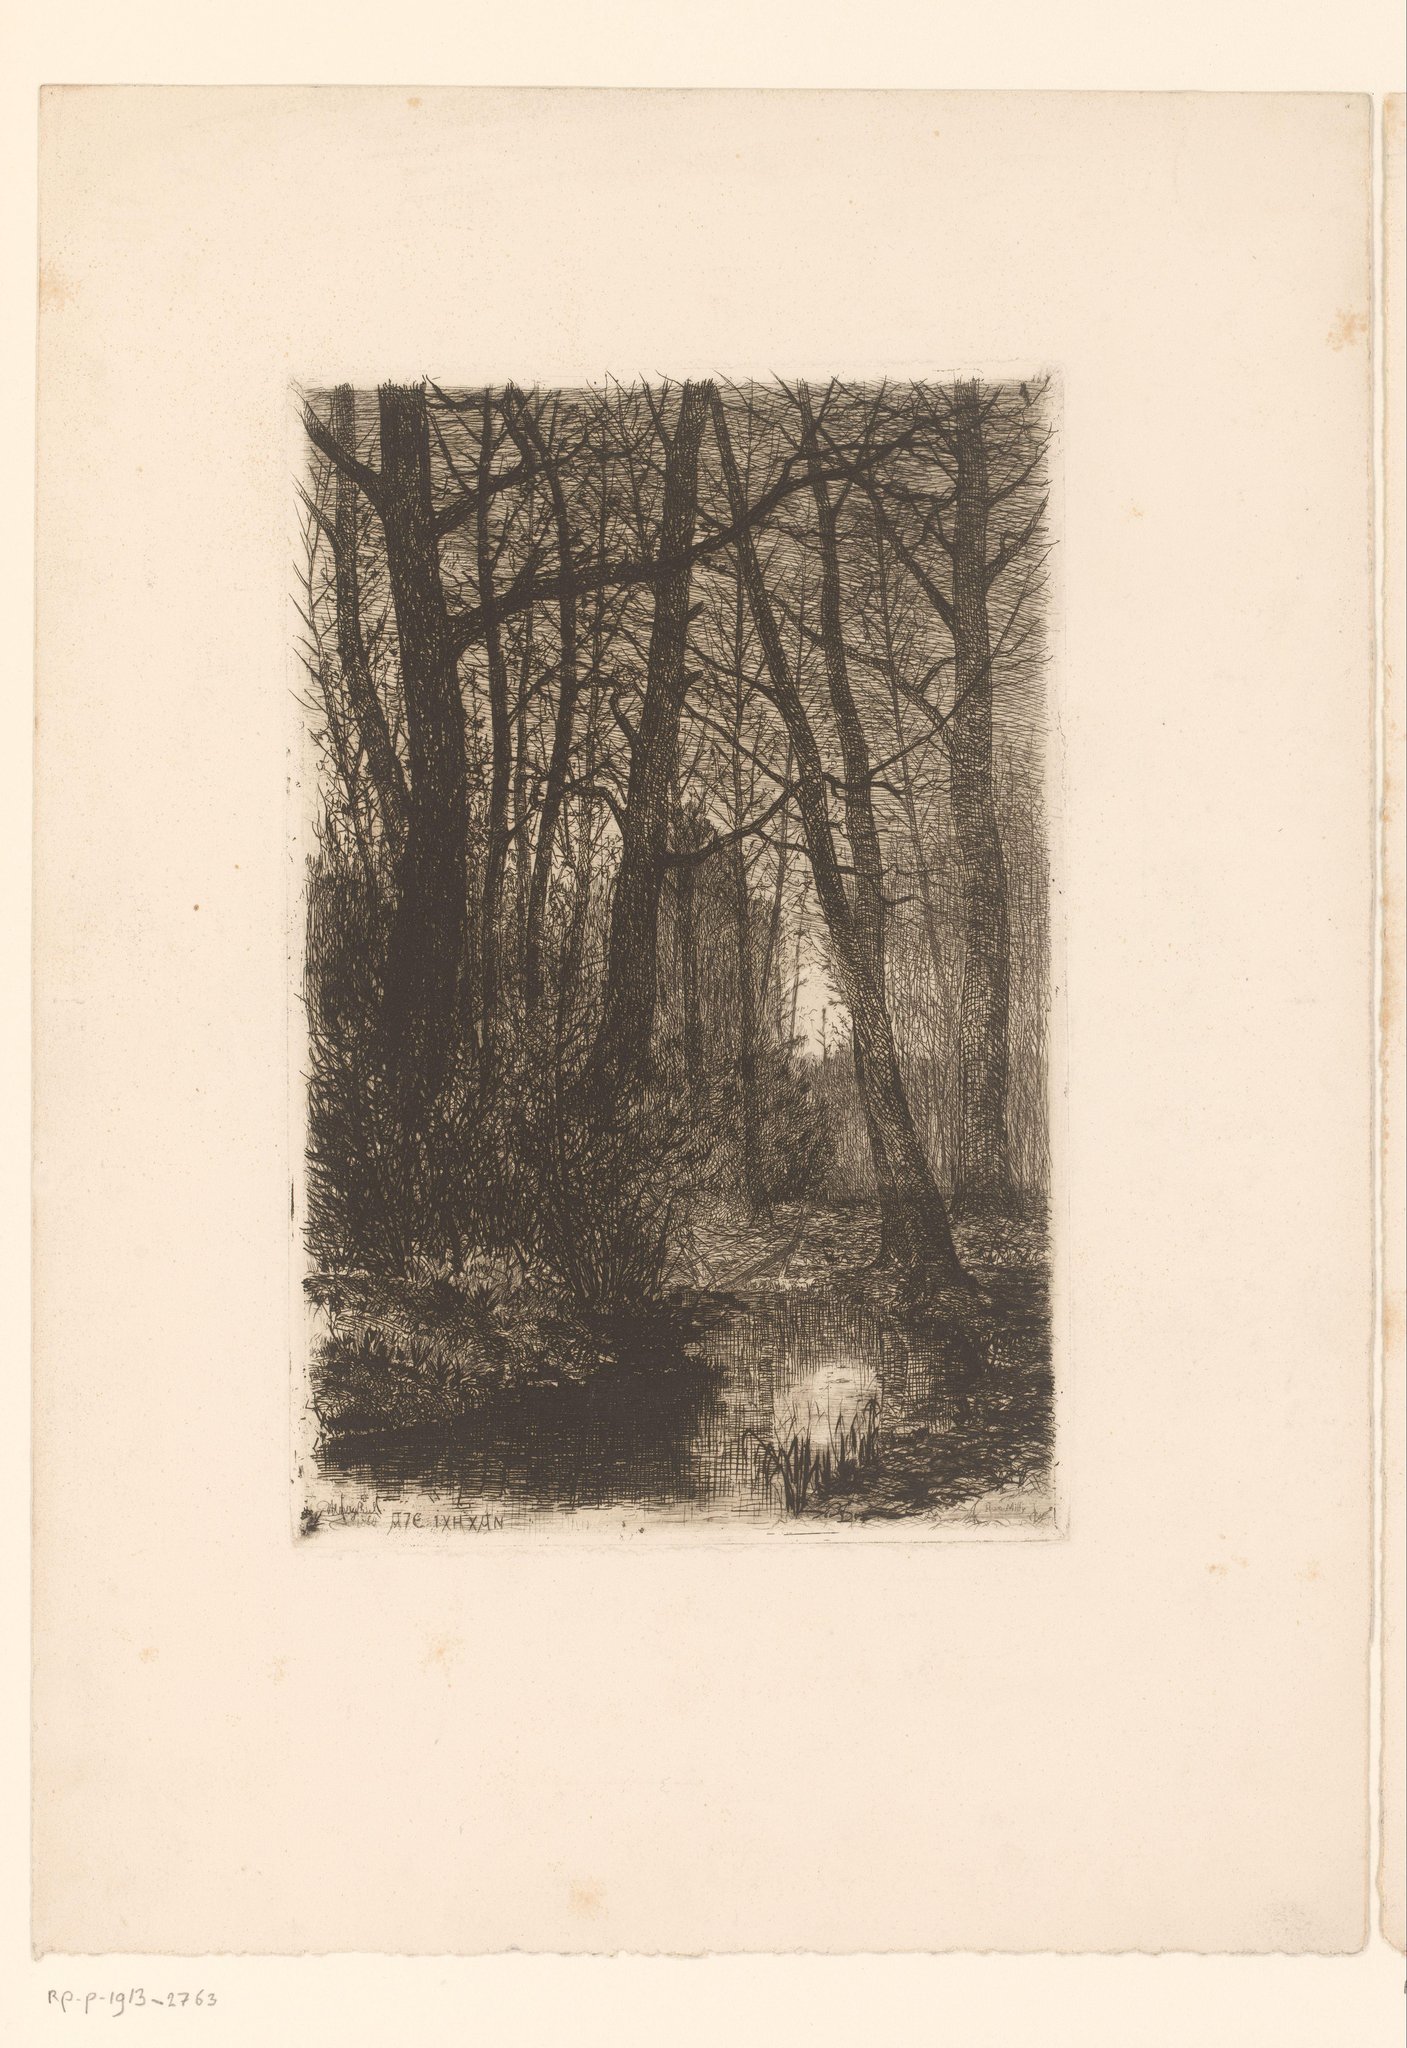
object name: print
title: Bos met sloot bij maanlicht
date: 1884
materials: paper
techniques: etching, retroussage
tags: moonlight, forest, wood, brook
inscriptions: mark: ‘Aan Milly’, collector's mark: Lugt 2228